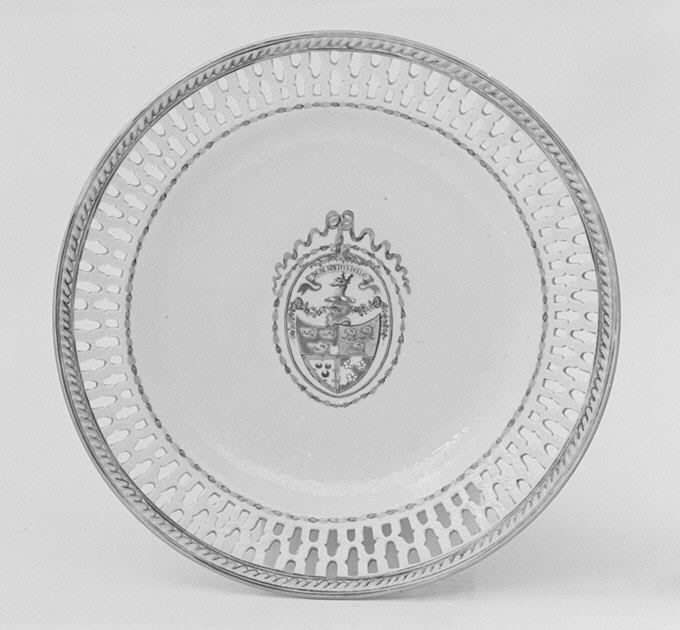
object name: plate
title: Plate (part of a service)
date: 1770-1785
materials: hard paste porcelain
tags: coat of arms